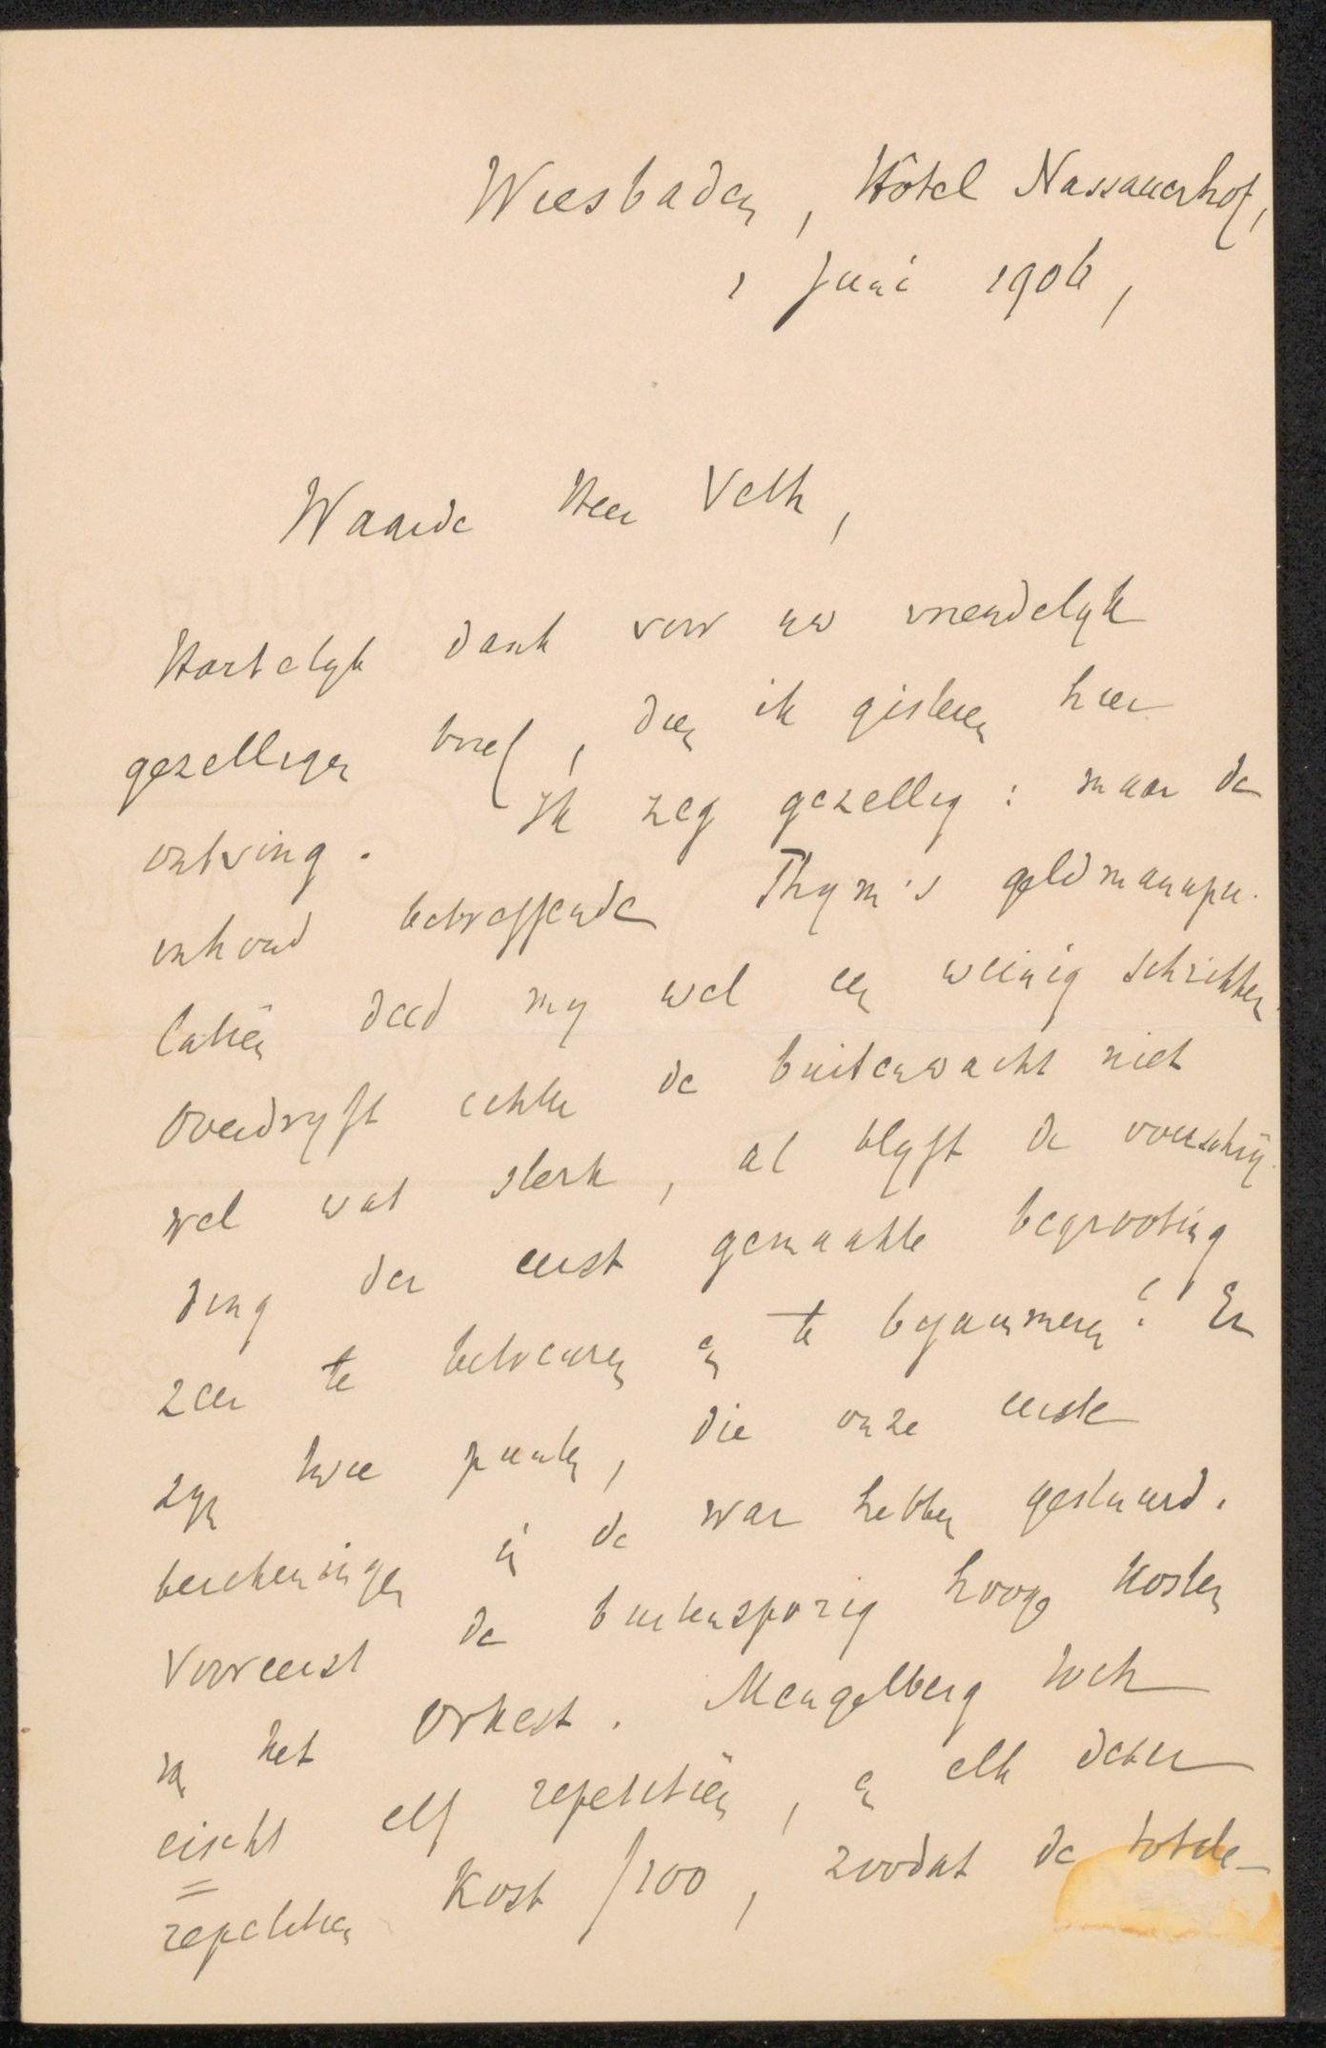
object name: letter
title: Brief aan Jan Veth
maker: hendrick peter godfried quack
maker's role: econoom, geschiedschrijver, hoogleraar, jurist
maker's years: 1834-1917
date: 1906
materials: ink, paper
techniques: pen, writing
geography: wiesbaden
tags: dordrecht, amsterdam, painter, print maker, draughtsman, designer, jan veth, the hague, marius bauer, ko cossaar, lodewijk van deyssel, utrecht, money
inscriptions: watermark, collector's mark: ‘RPK’